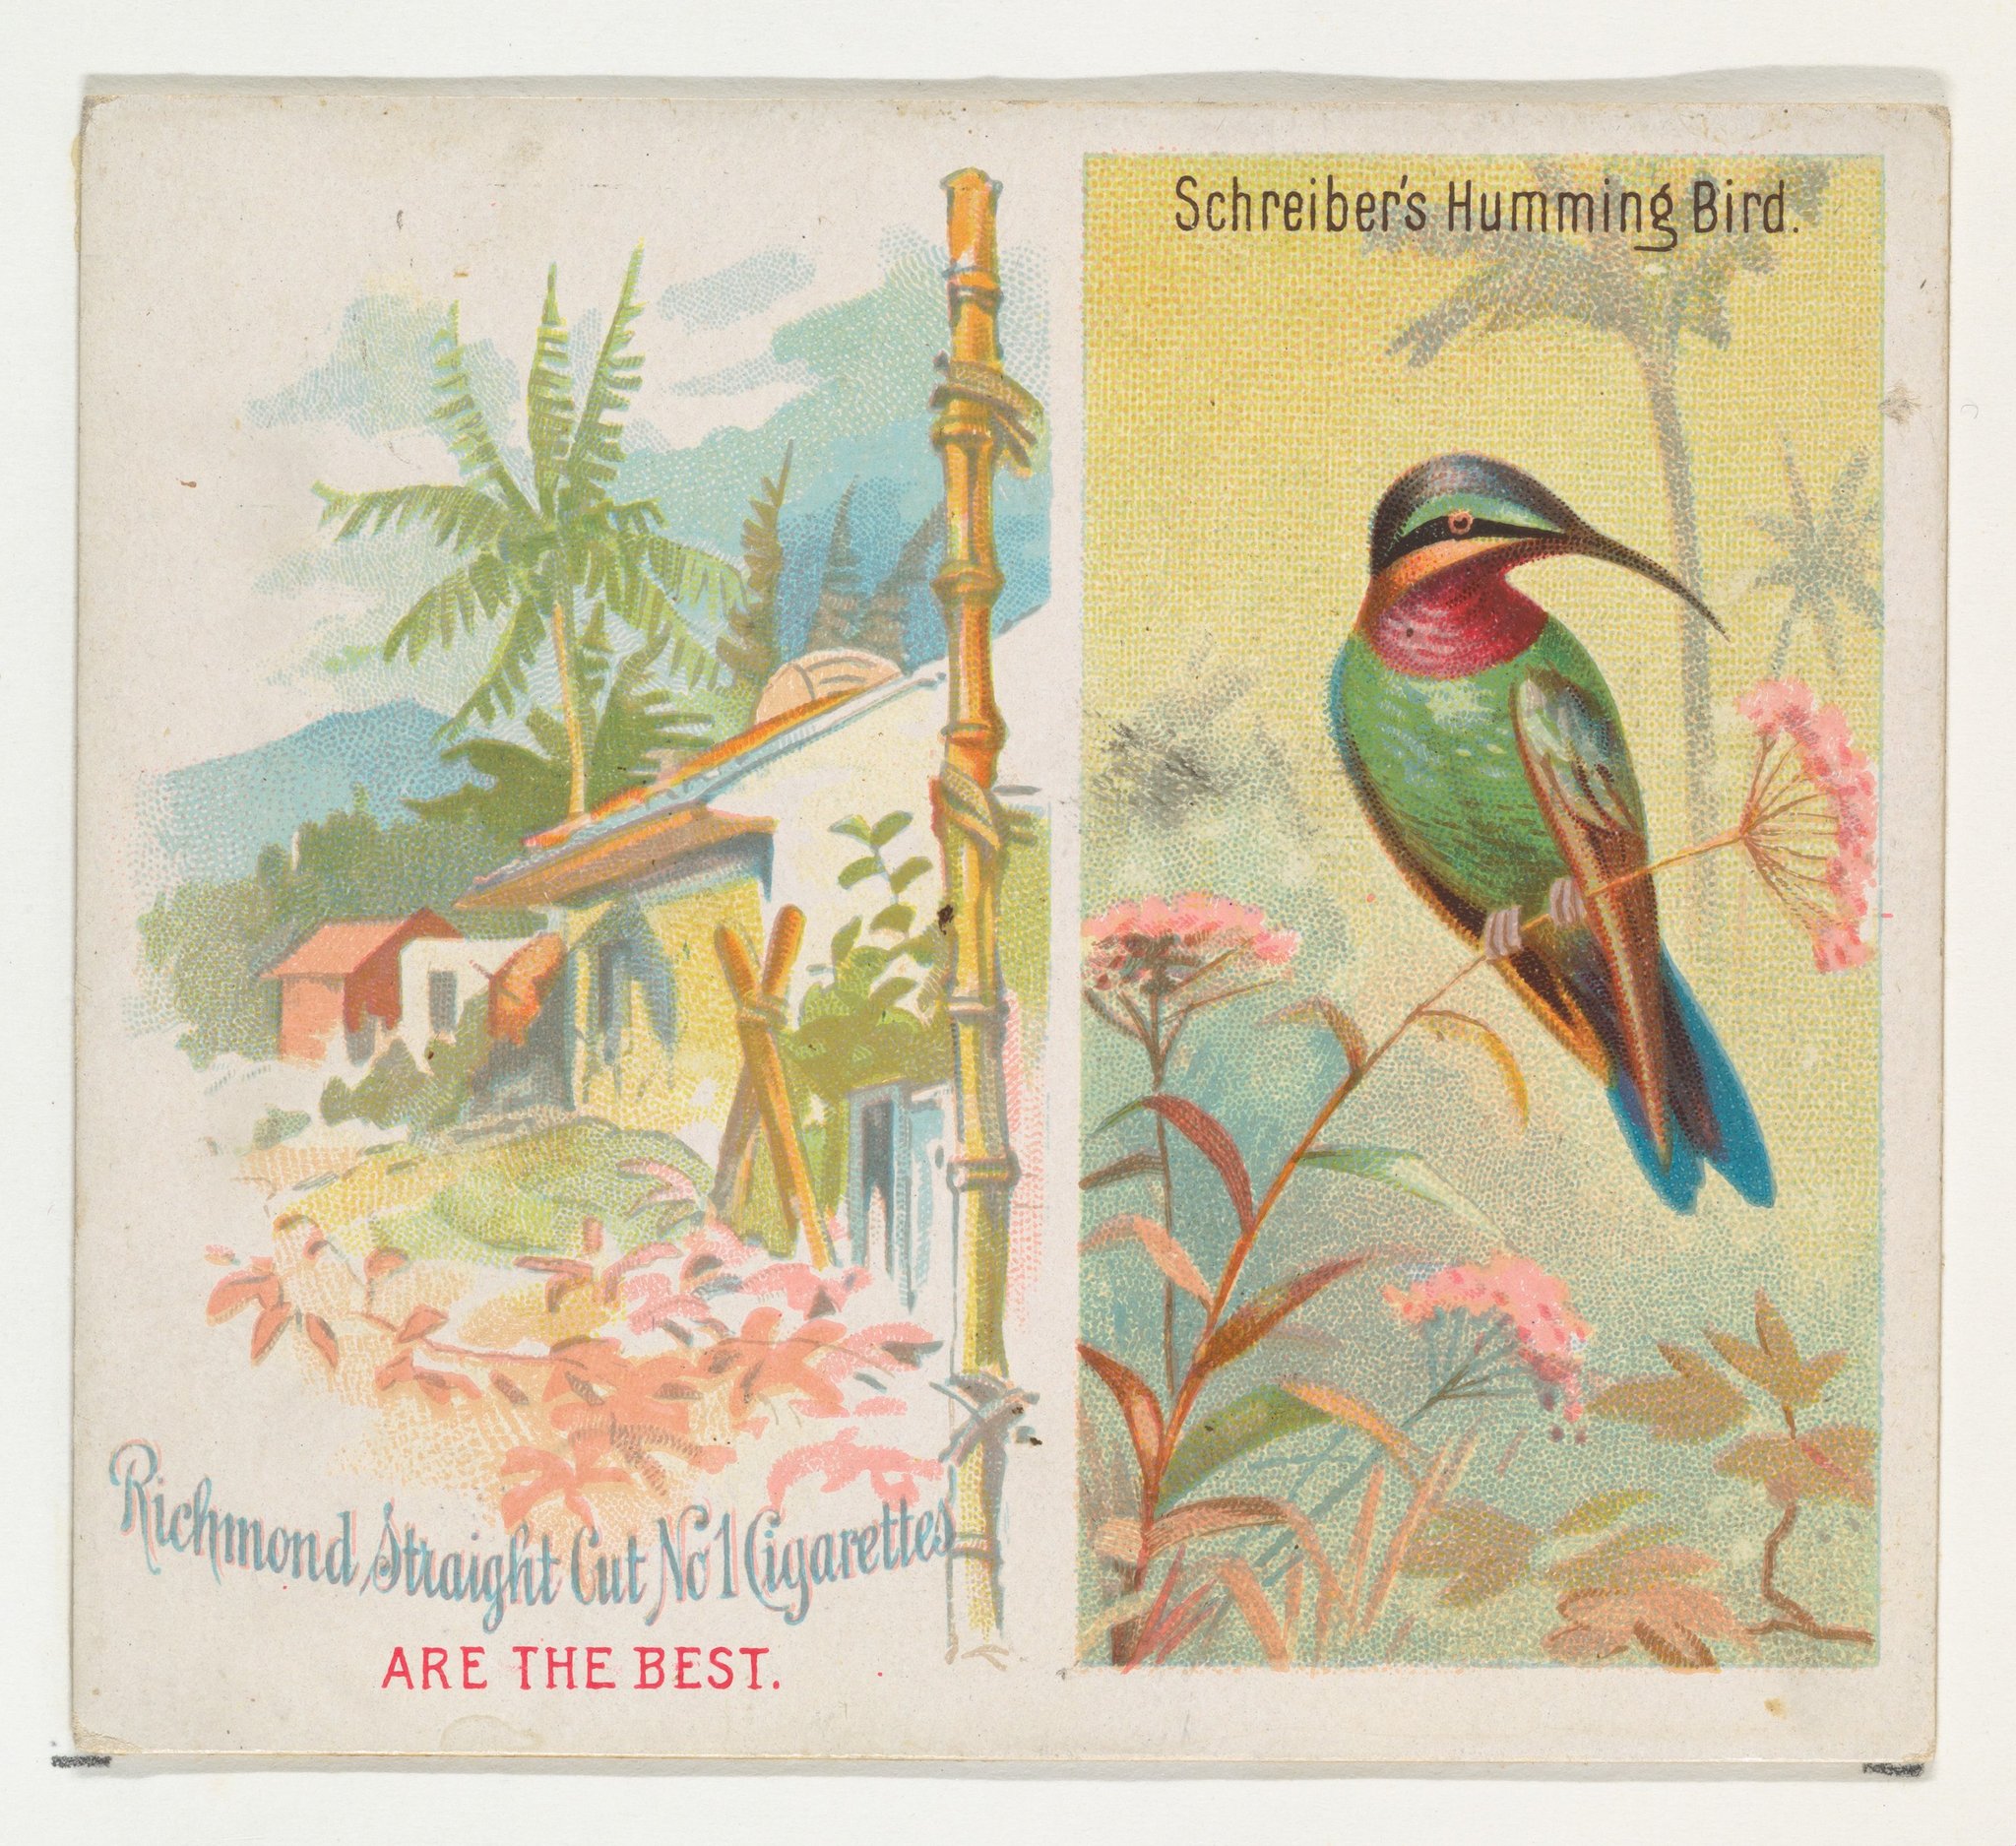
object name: print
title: Schreiber's Hummingbird, from Birds of the Tropics series (N38) for Allen & Ginter Cigarettes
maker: allen & ginter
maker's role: publisher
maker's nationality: american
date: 1889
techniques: color lithograph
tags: birds